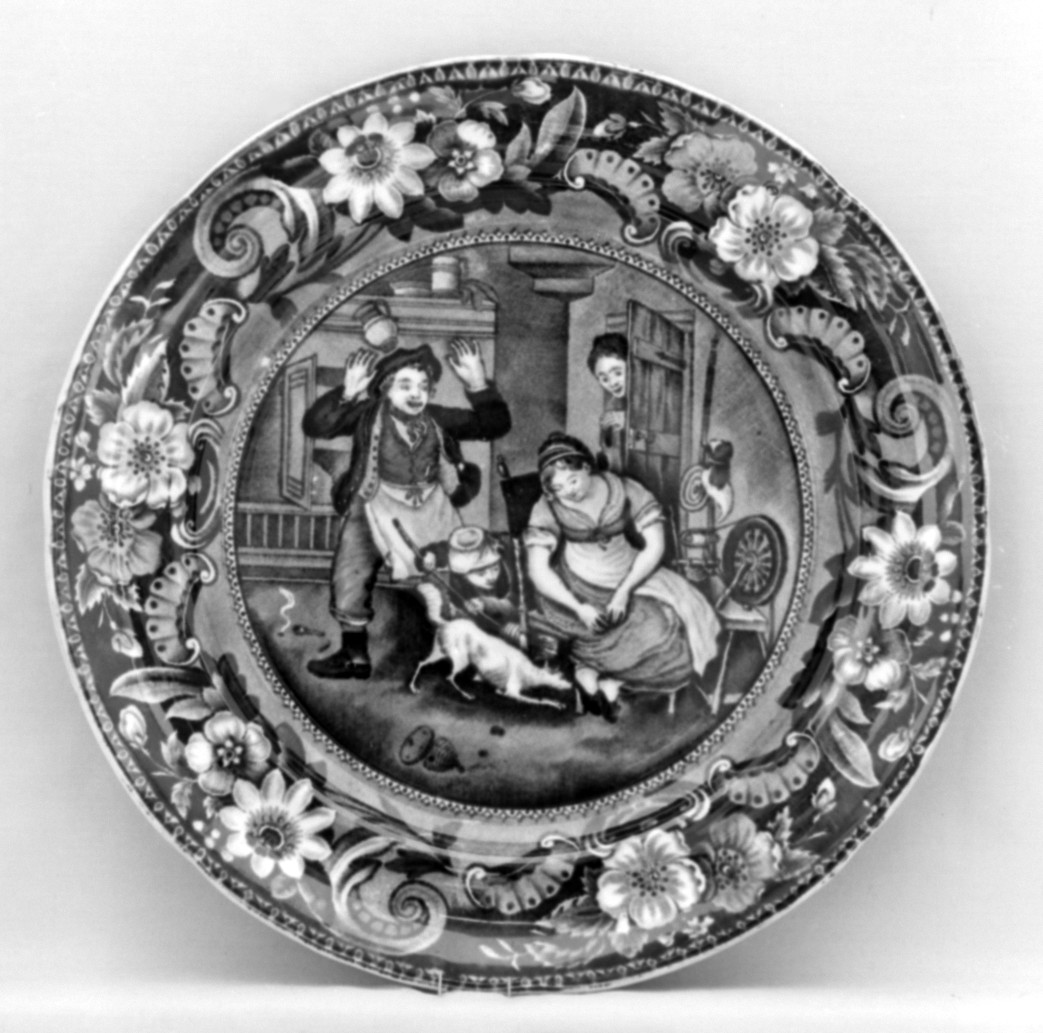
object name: plate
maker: james and ralph clews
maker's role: factory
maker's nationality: british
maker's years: 1813-1836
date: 1801-1900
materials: pottery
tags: interiors,men,women,dogs,flowers